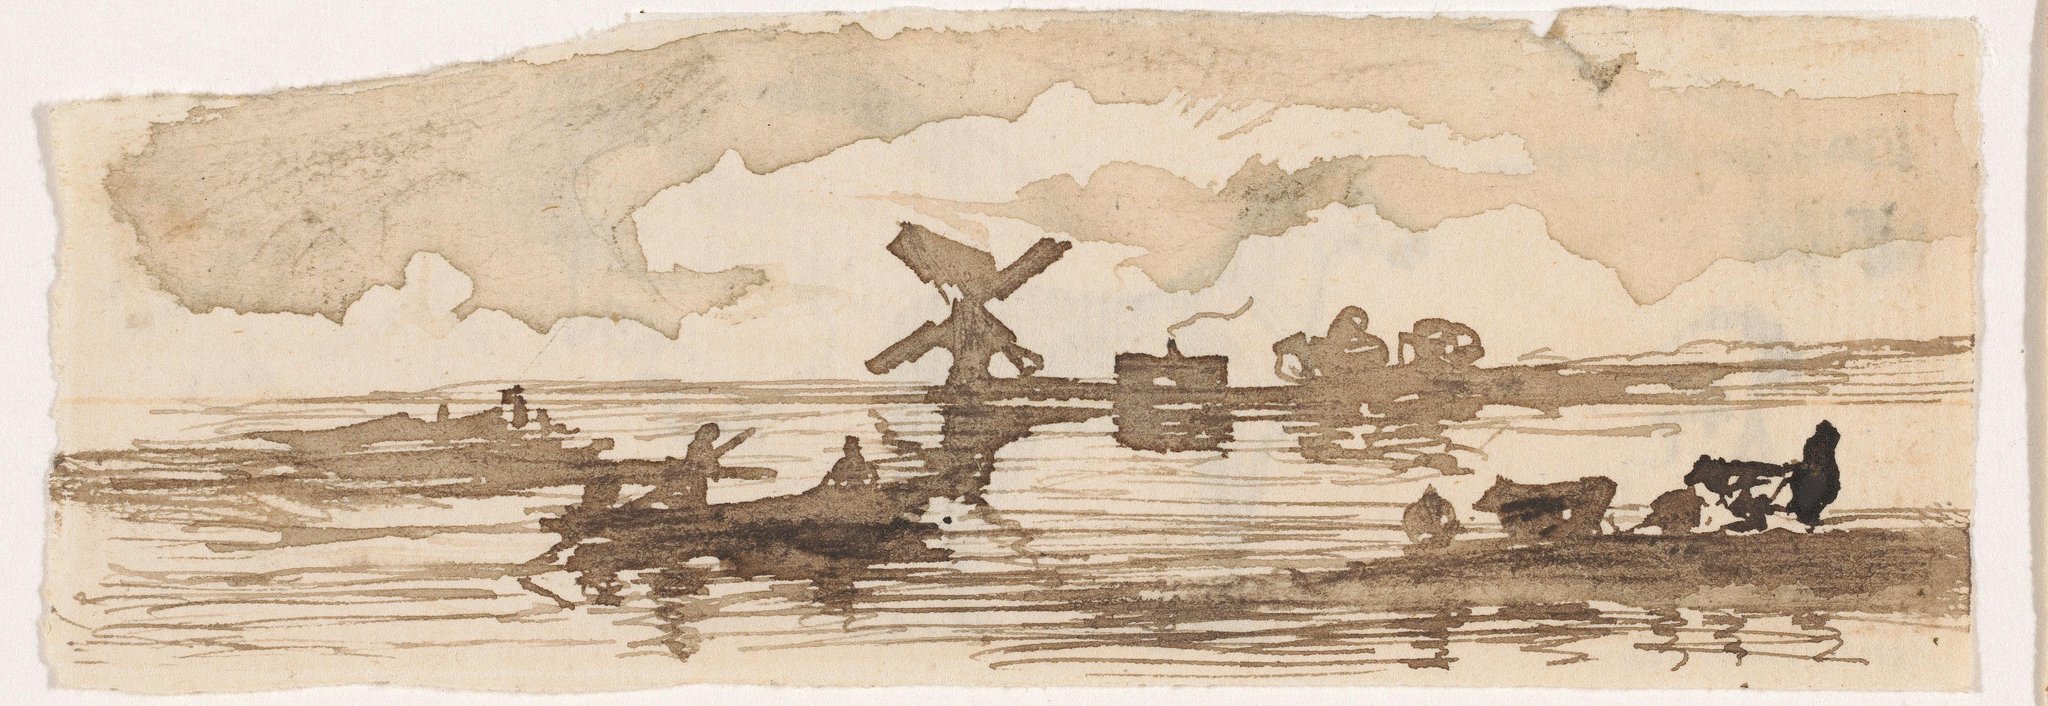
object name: drawing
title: Rivierlandschap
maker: johannes tavenraat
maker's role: draughtsman, painter, print maker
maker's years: 1809-1881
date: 1840-1880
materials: ink, paper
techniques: brush, pen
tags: windmill in landscape, river (+ landscape with figures, staffage)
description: Rivierlandschap met vee, roeiboot en een molen